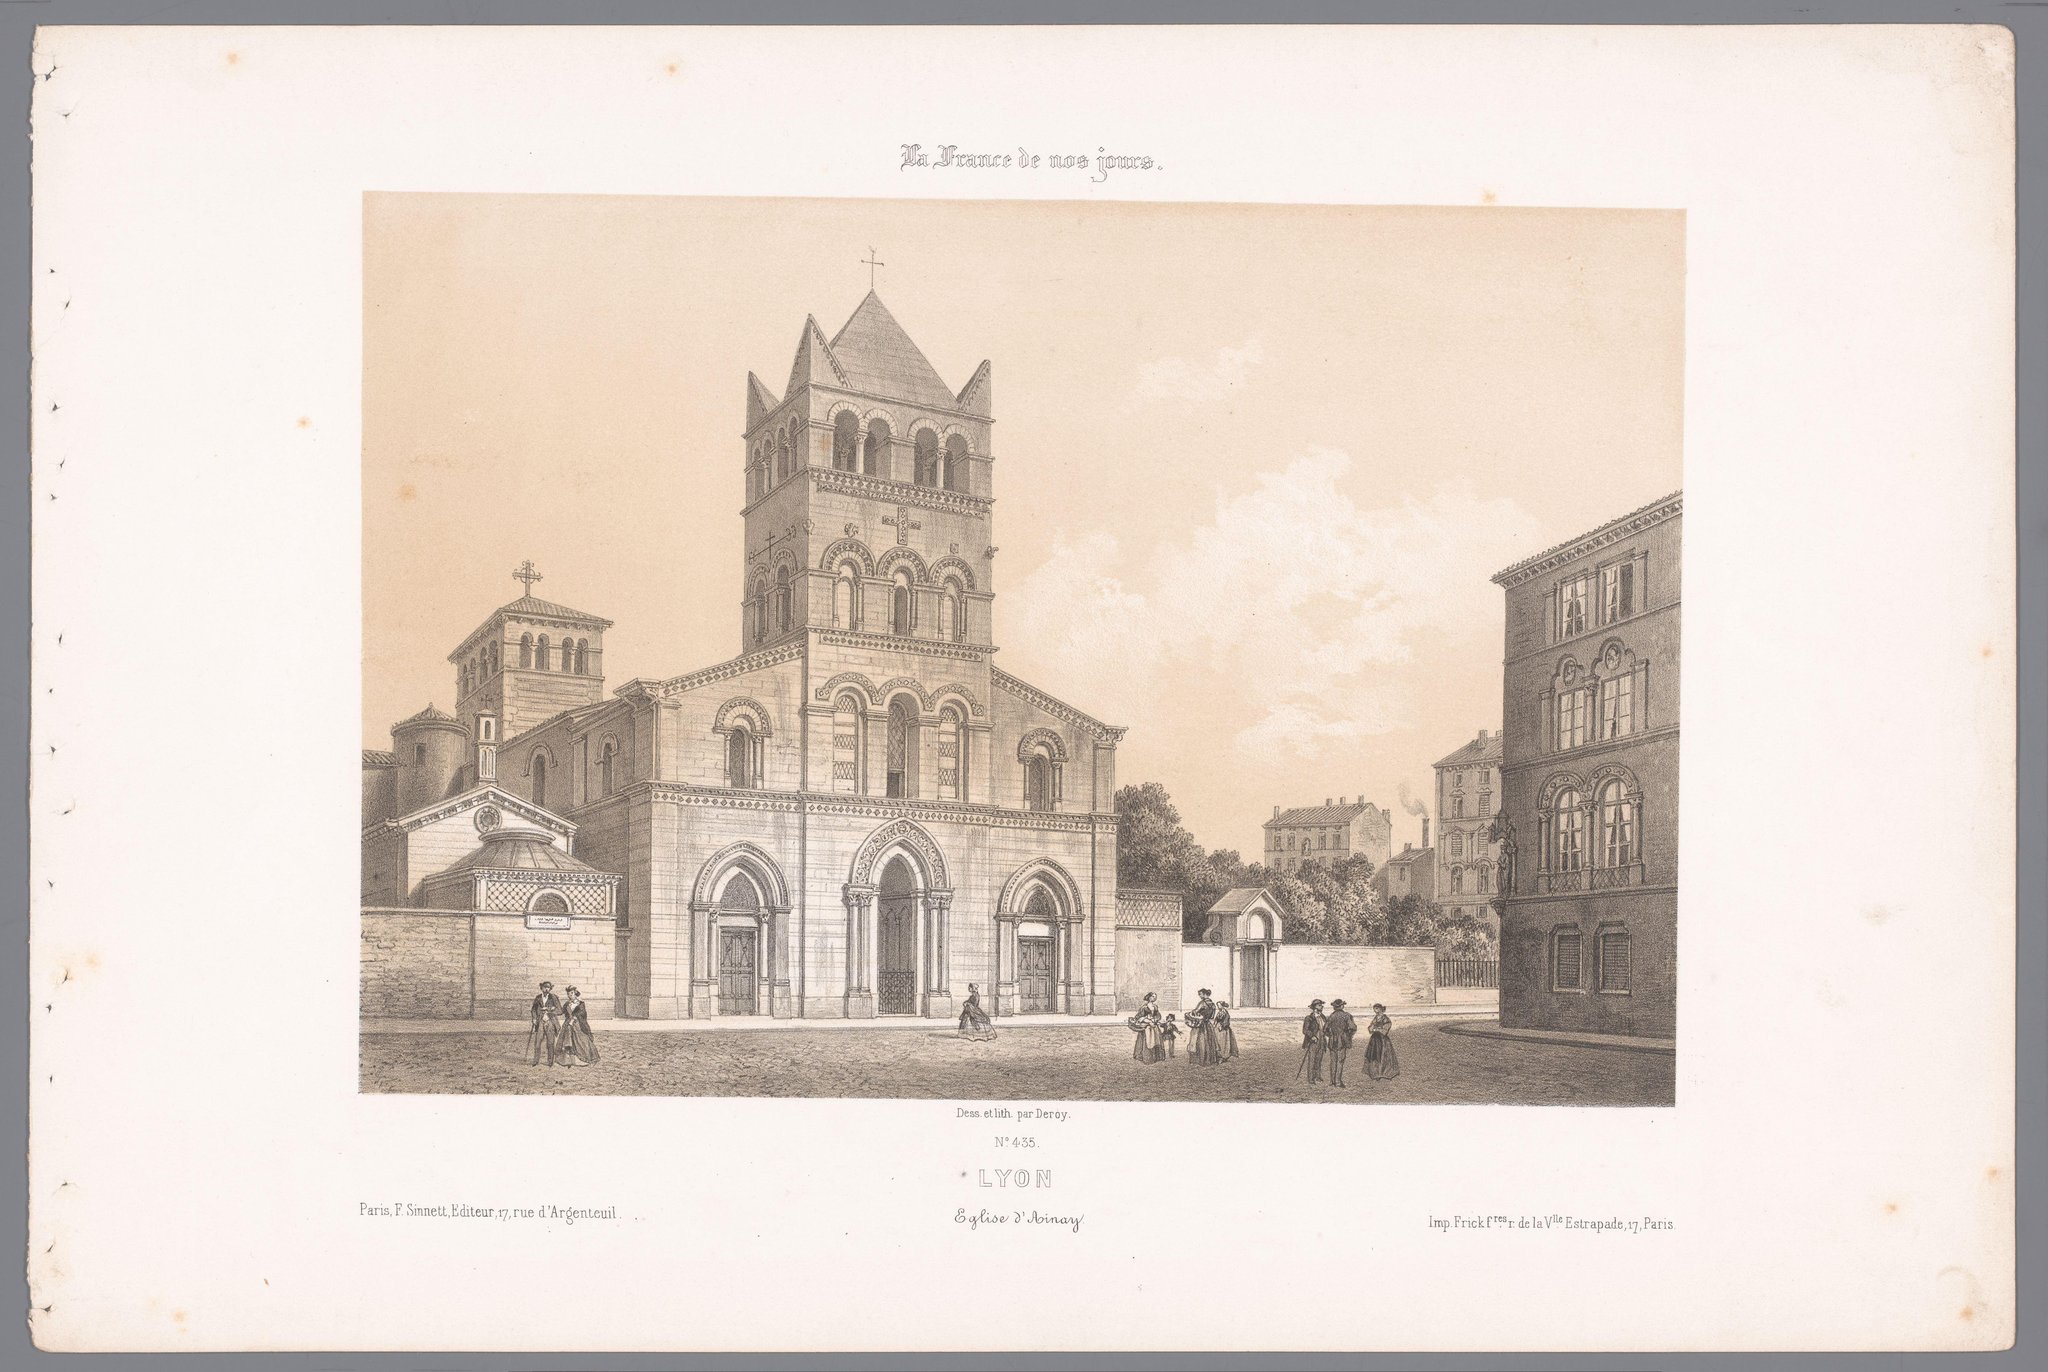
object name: print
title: Hedendaags Frankrijk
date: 1861-1872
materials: paper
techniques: tone lithography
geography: paris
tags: church (exterior)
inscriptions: collector's mark: Lugt 2228a